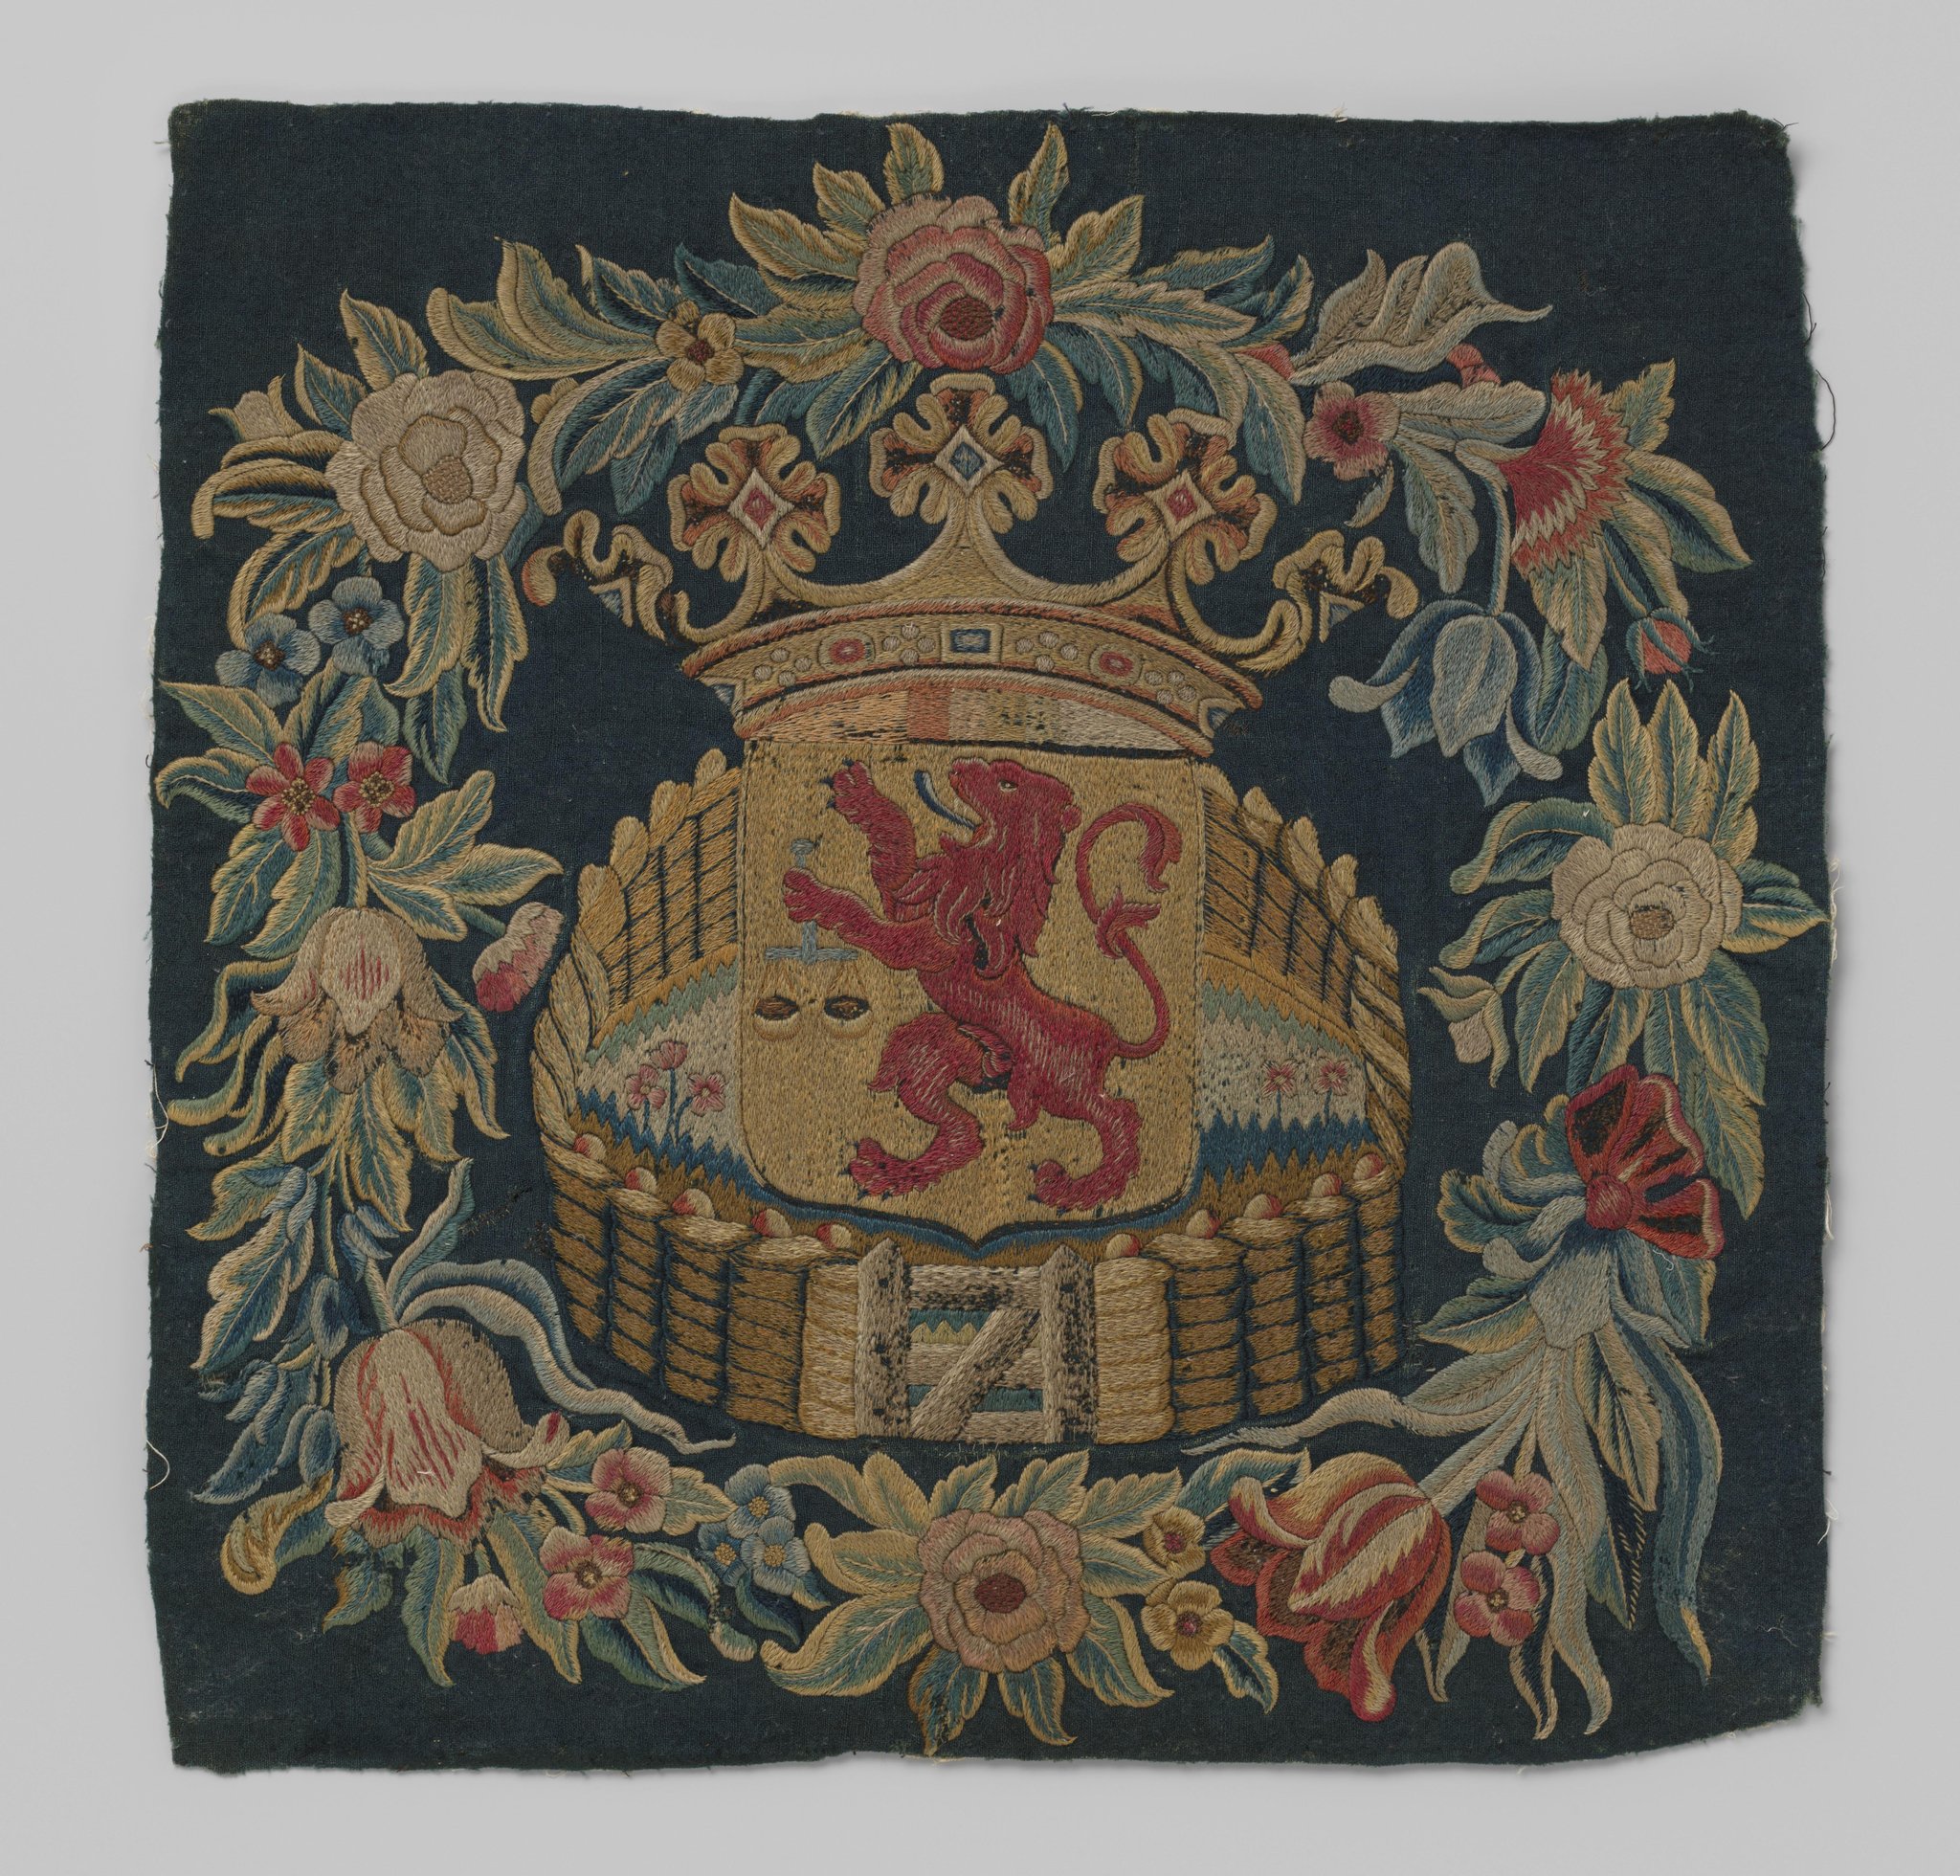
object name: magistratenkussen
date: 1600-1699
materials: silk, wool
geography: northern netherlands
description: Magistratenkussen van groenblauw laken versierd met de "Hollandse tuin" met de Hollandse leeuw in zijden borduursel.